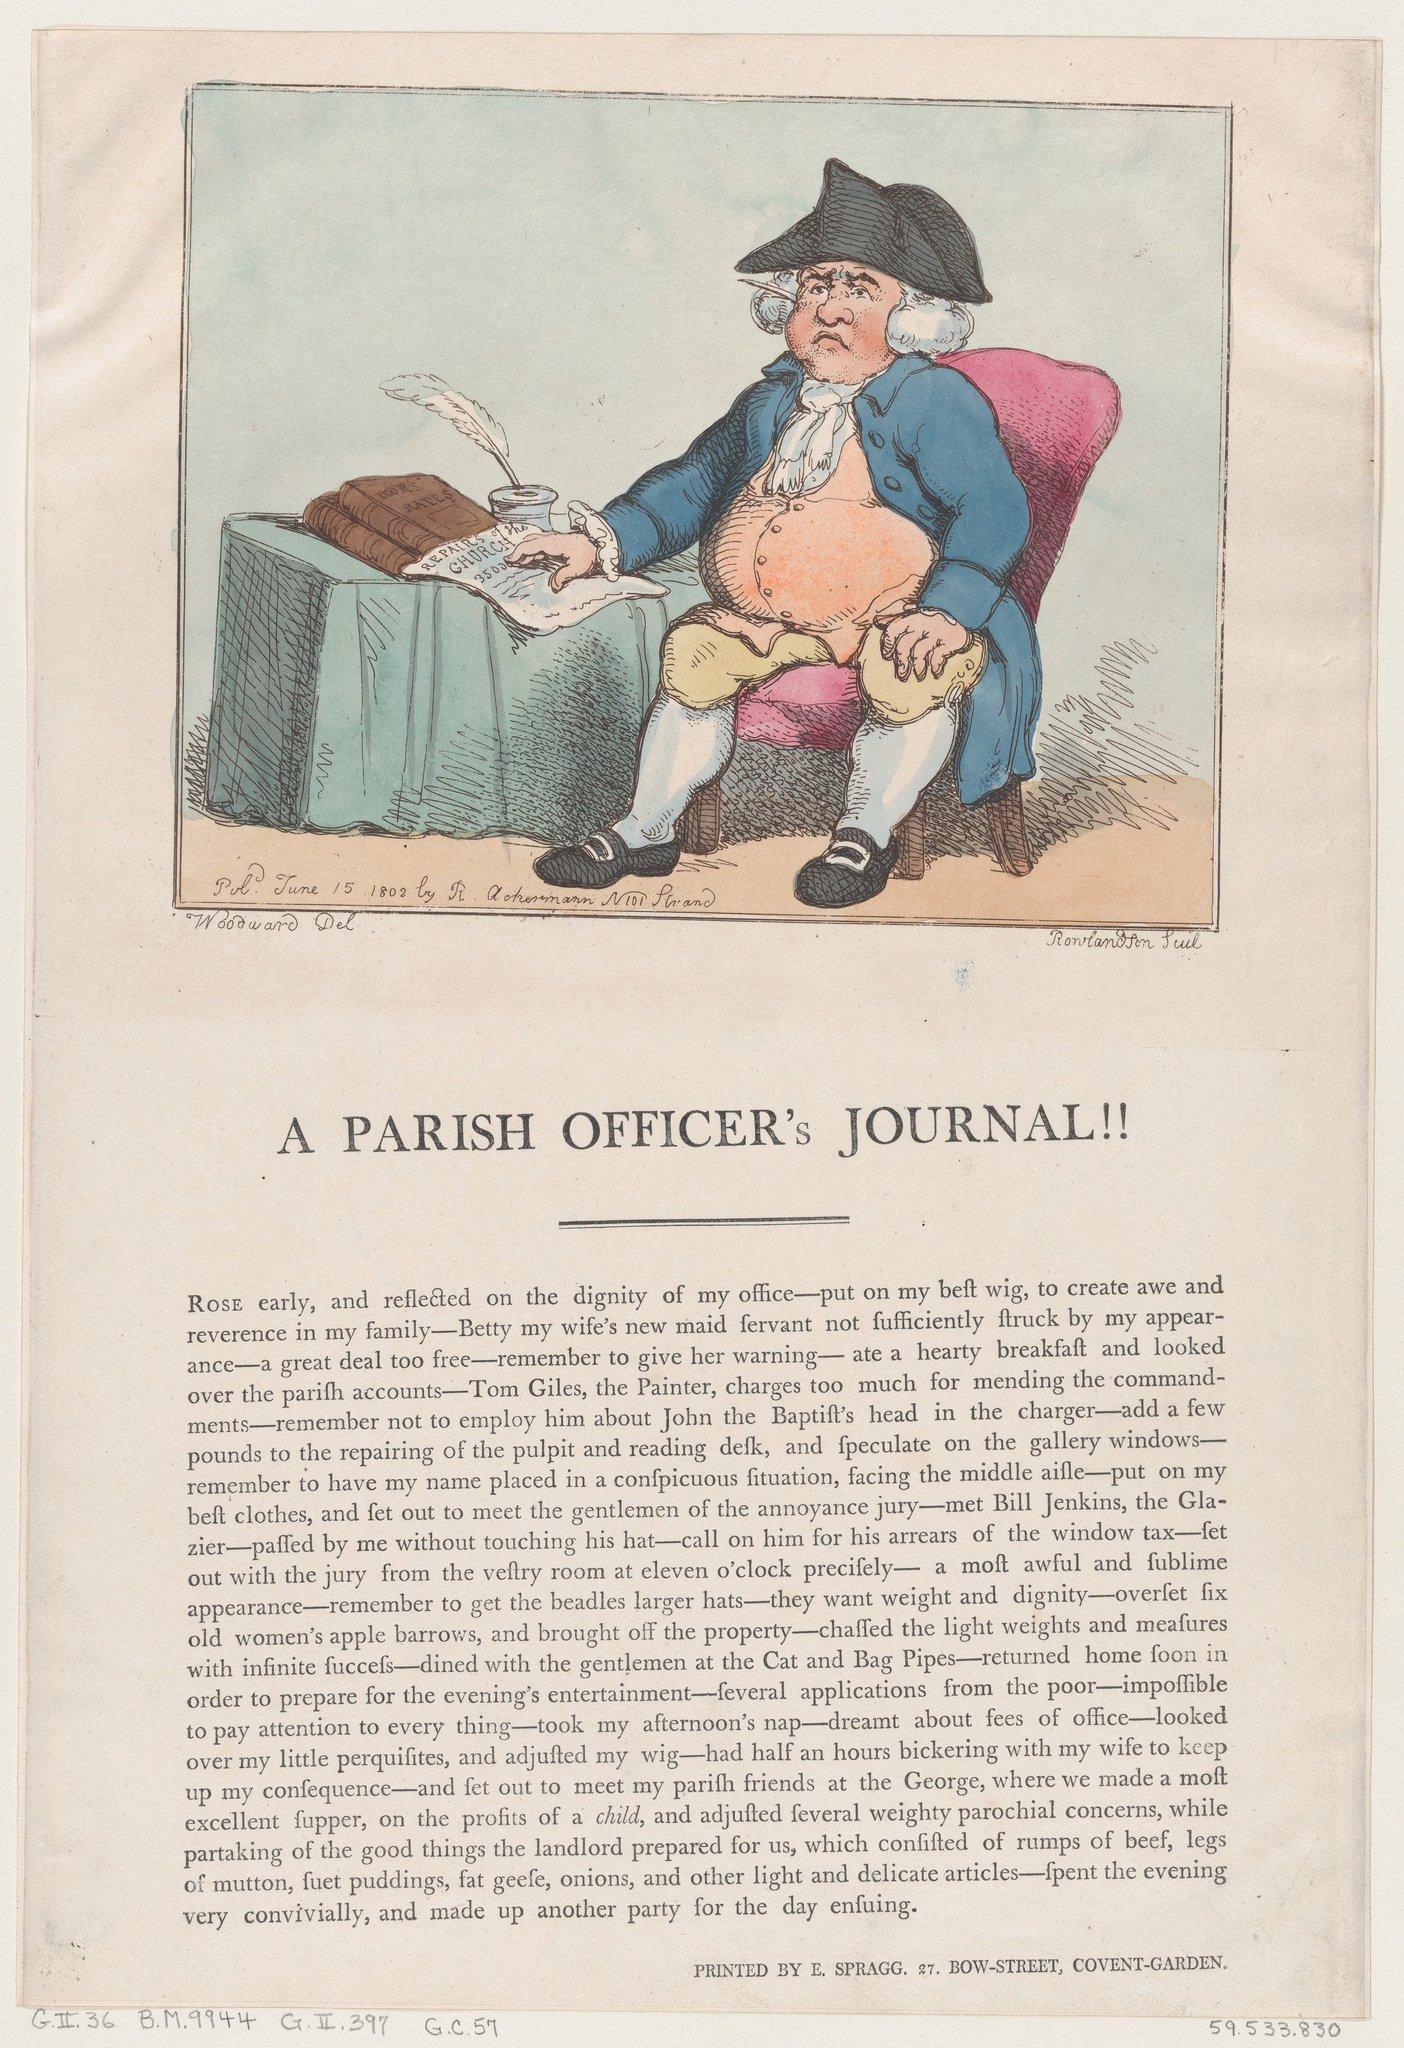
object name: print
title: A Parish Officer's Journal!!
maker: thomas rowlandson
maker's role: artist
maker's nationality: british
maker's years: 1757-1827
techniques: etching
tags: satire,men